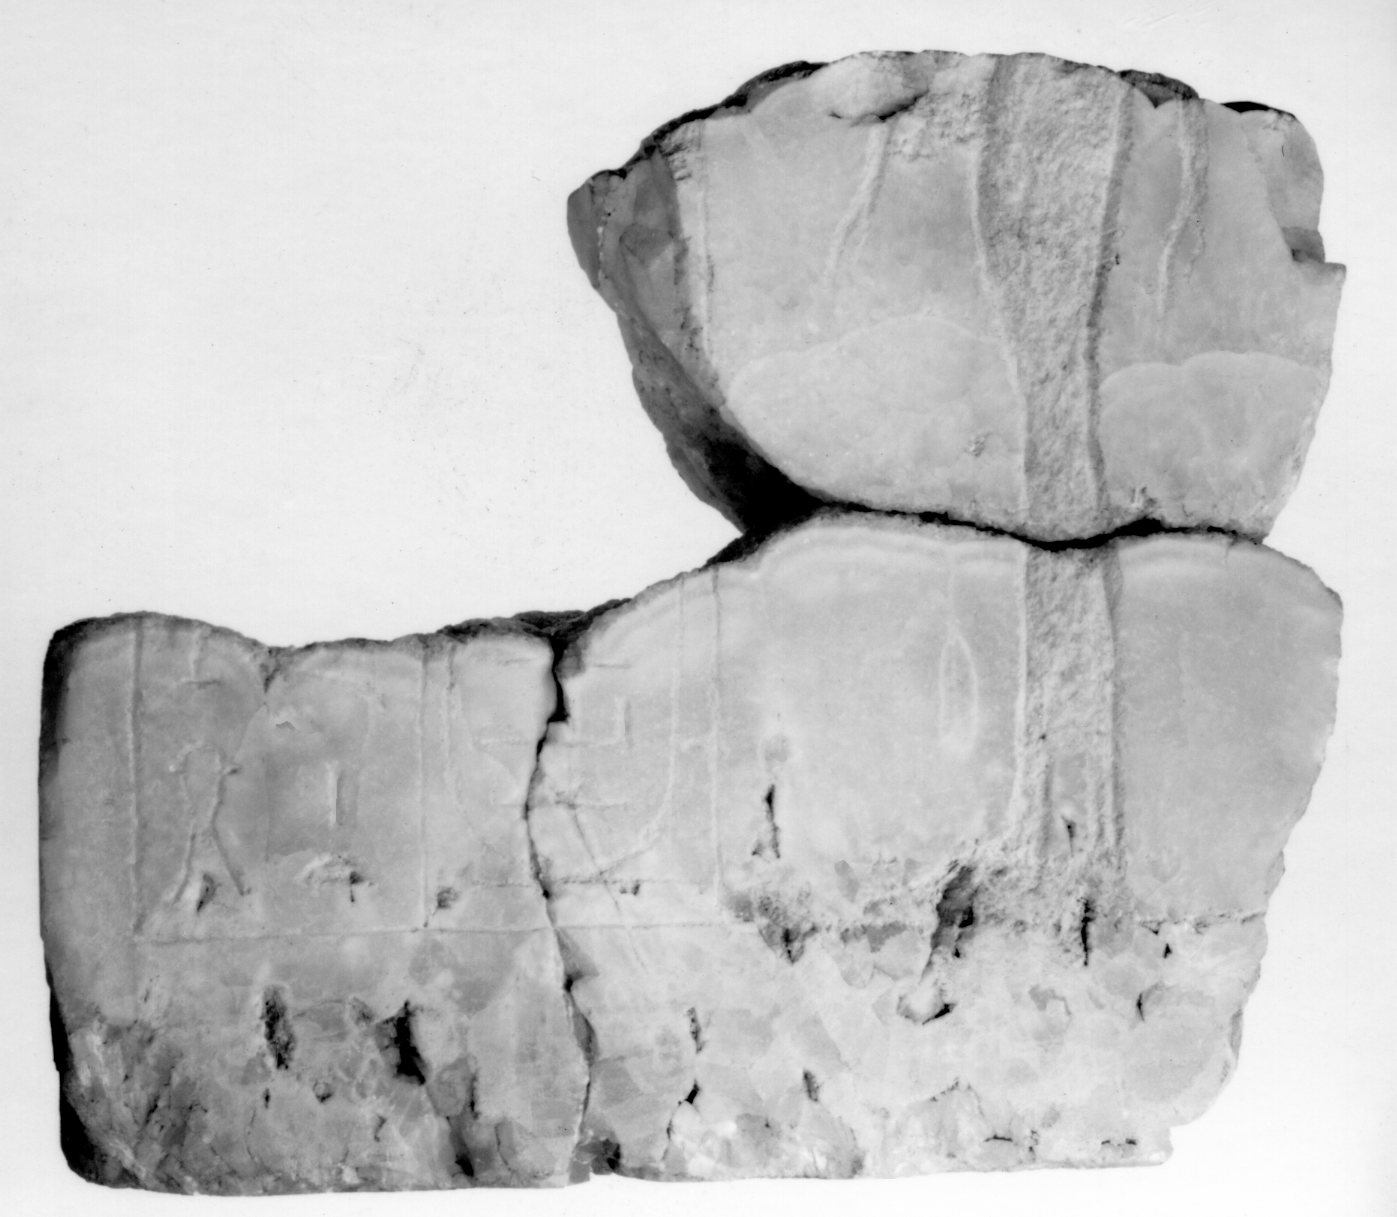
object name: canopic chest, tiye, thutmose iv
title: Fragment of a Canopic Chest of Queen Tiya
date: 1427-1390 BCE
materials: stone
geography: egypt